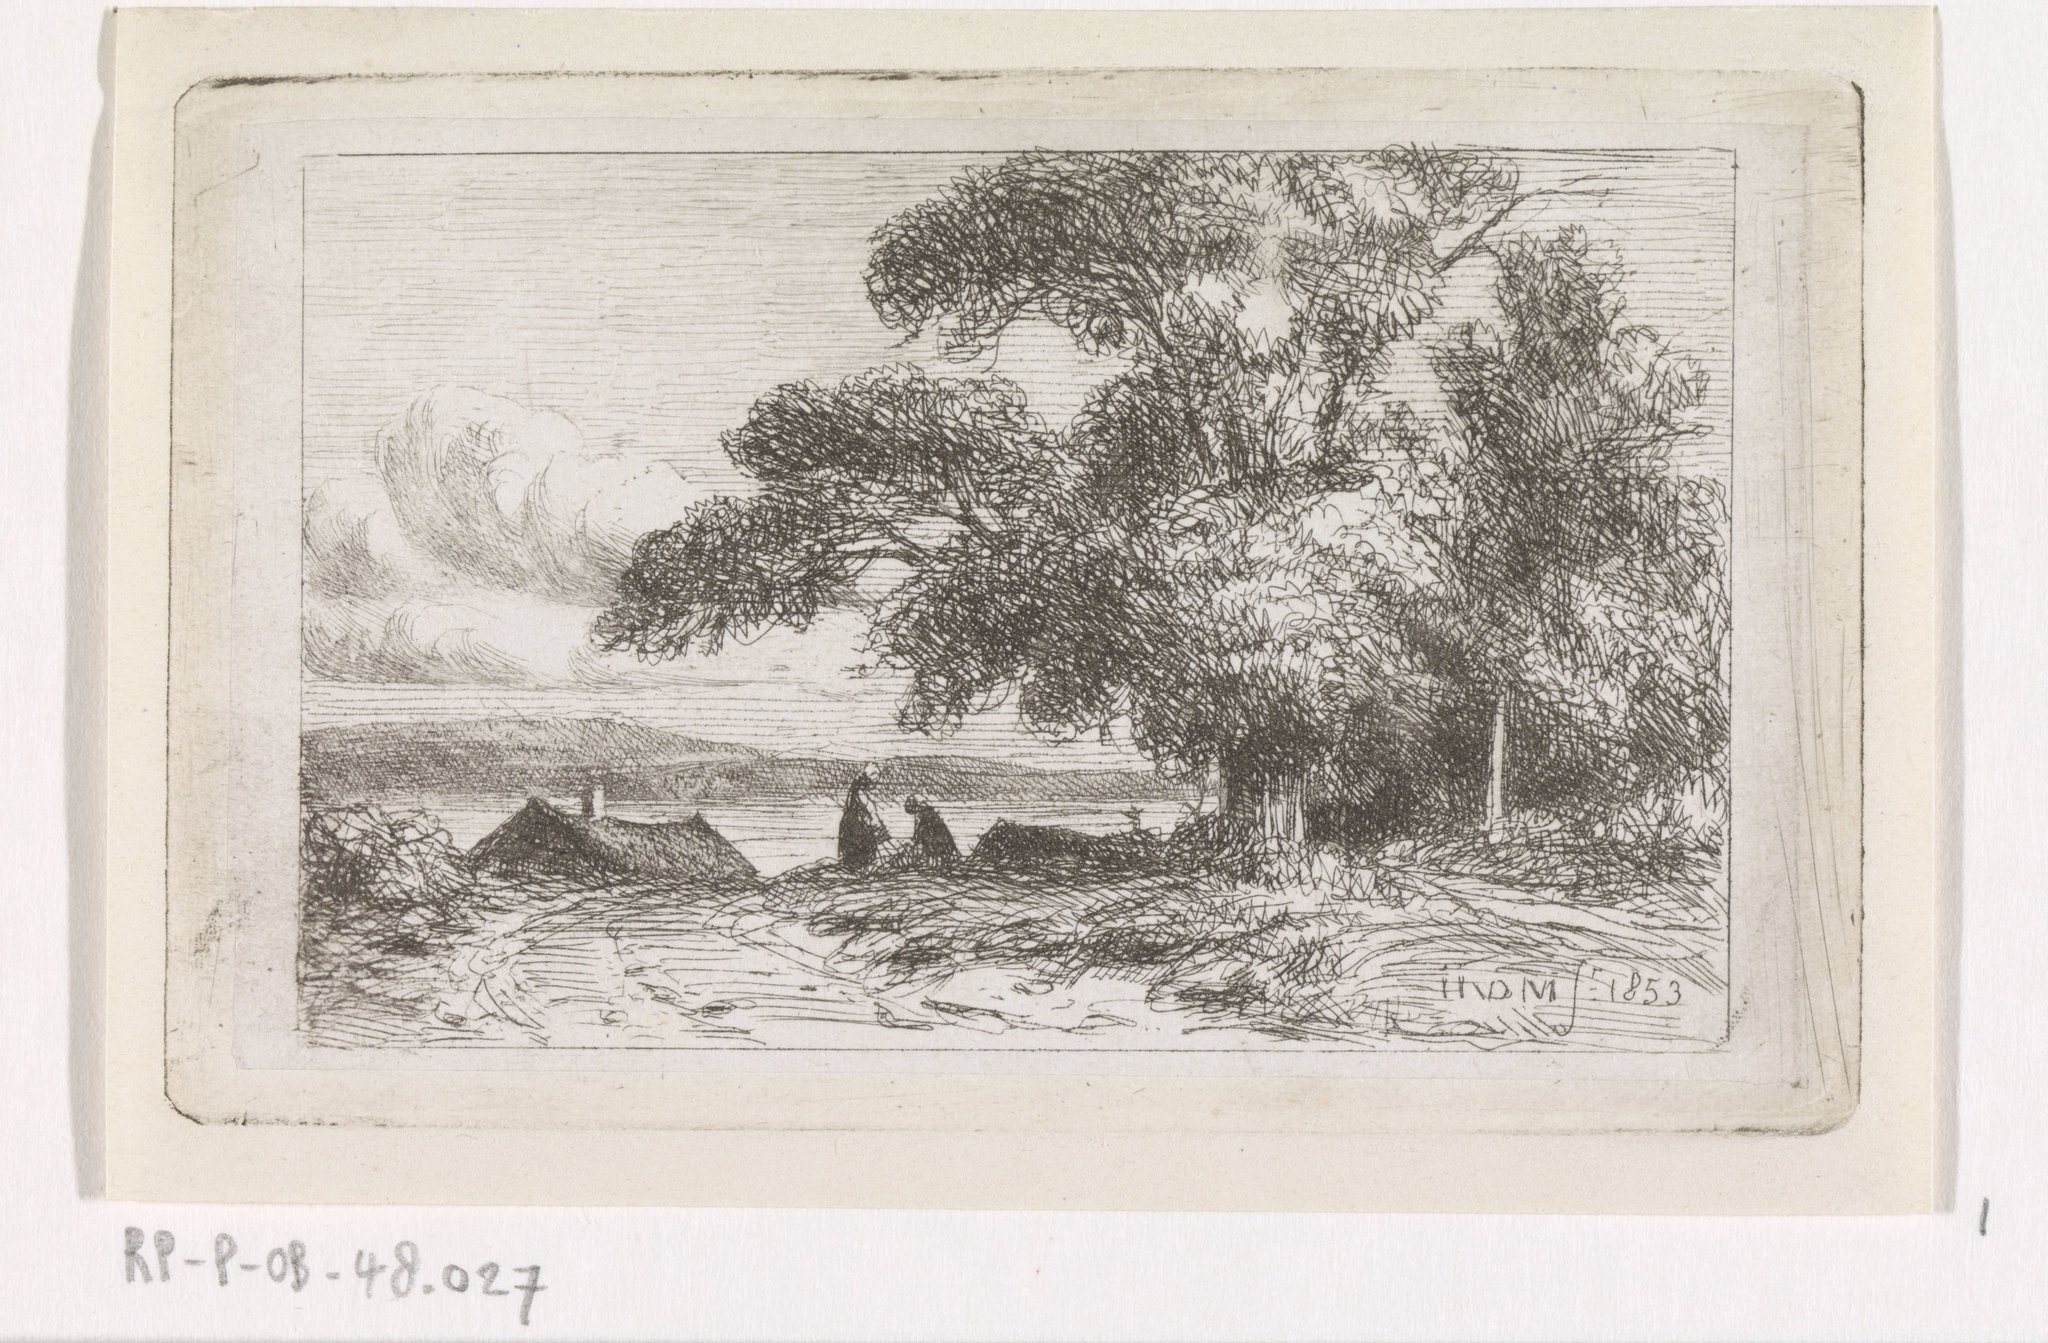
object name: print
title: Figuren aan een landweg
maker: jacob jan van der maaten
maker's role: draughtsman, print maker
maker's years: 1820-1879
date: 1853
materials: paper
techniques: etching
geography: the hague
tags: trees, landscapes in the temperate zone (+ landscape with figures, staffage)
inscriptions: collector's mark: Lugt 2228